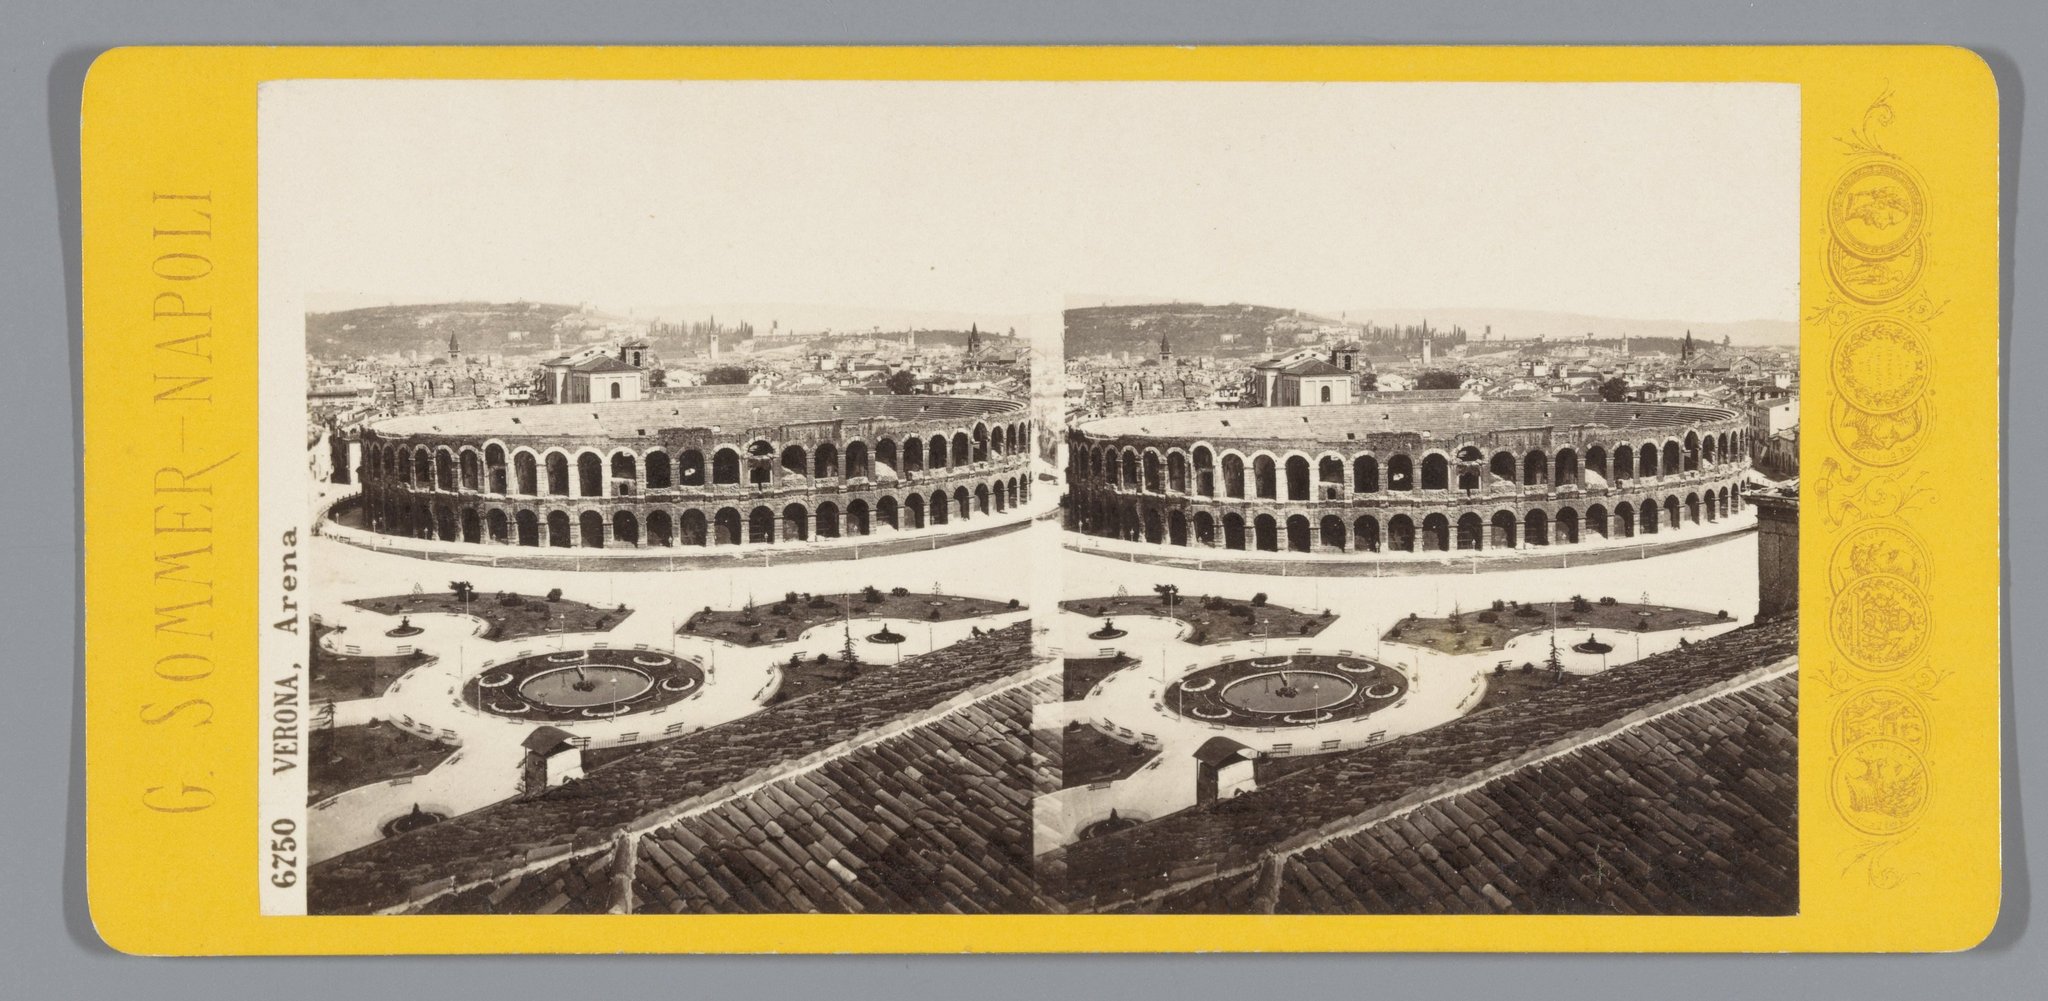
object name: stereograph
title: Gezicht op de Arena van Verona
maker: giorgio sommer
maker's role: fotograaf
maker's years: 1834-1914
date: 1860-1880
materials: cardboard, photographic support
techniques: albumen print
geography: verona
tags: amphitheatre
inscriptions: number: ‘6570’